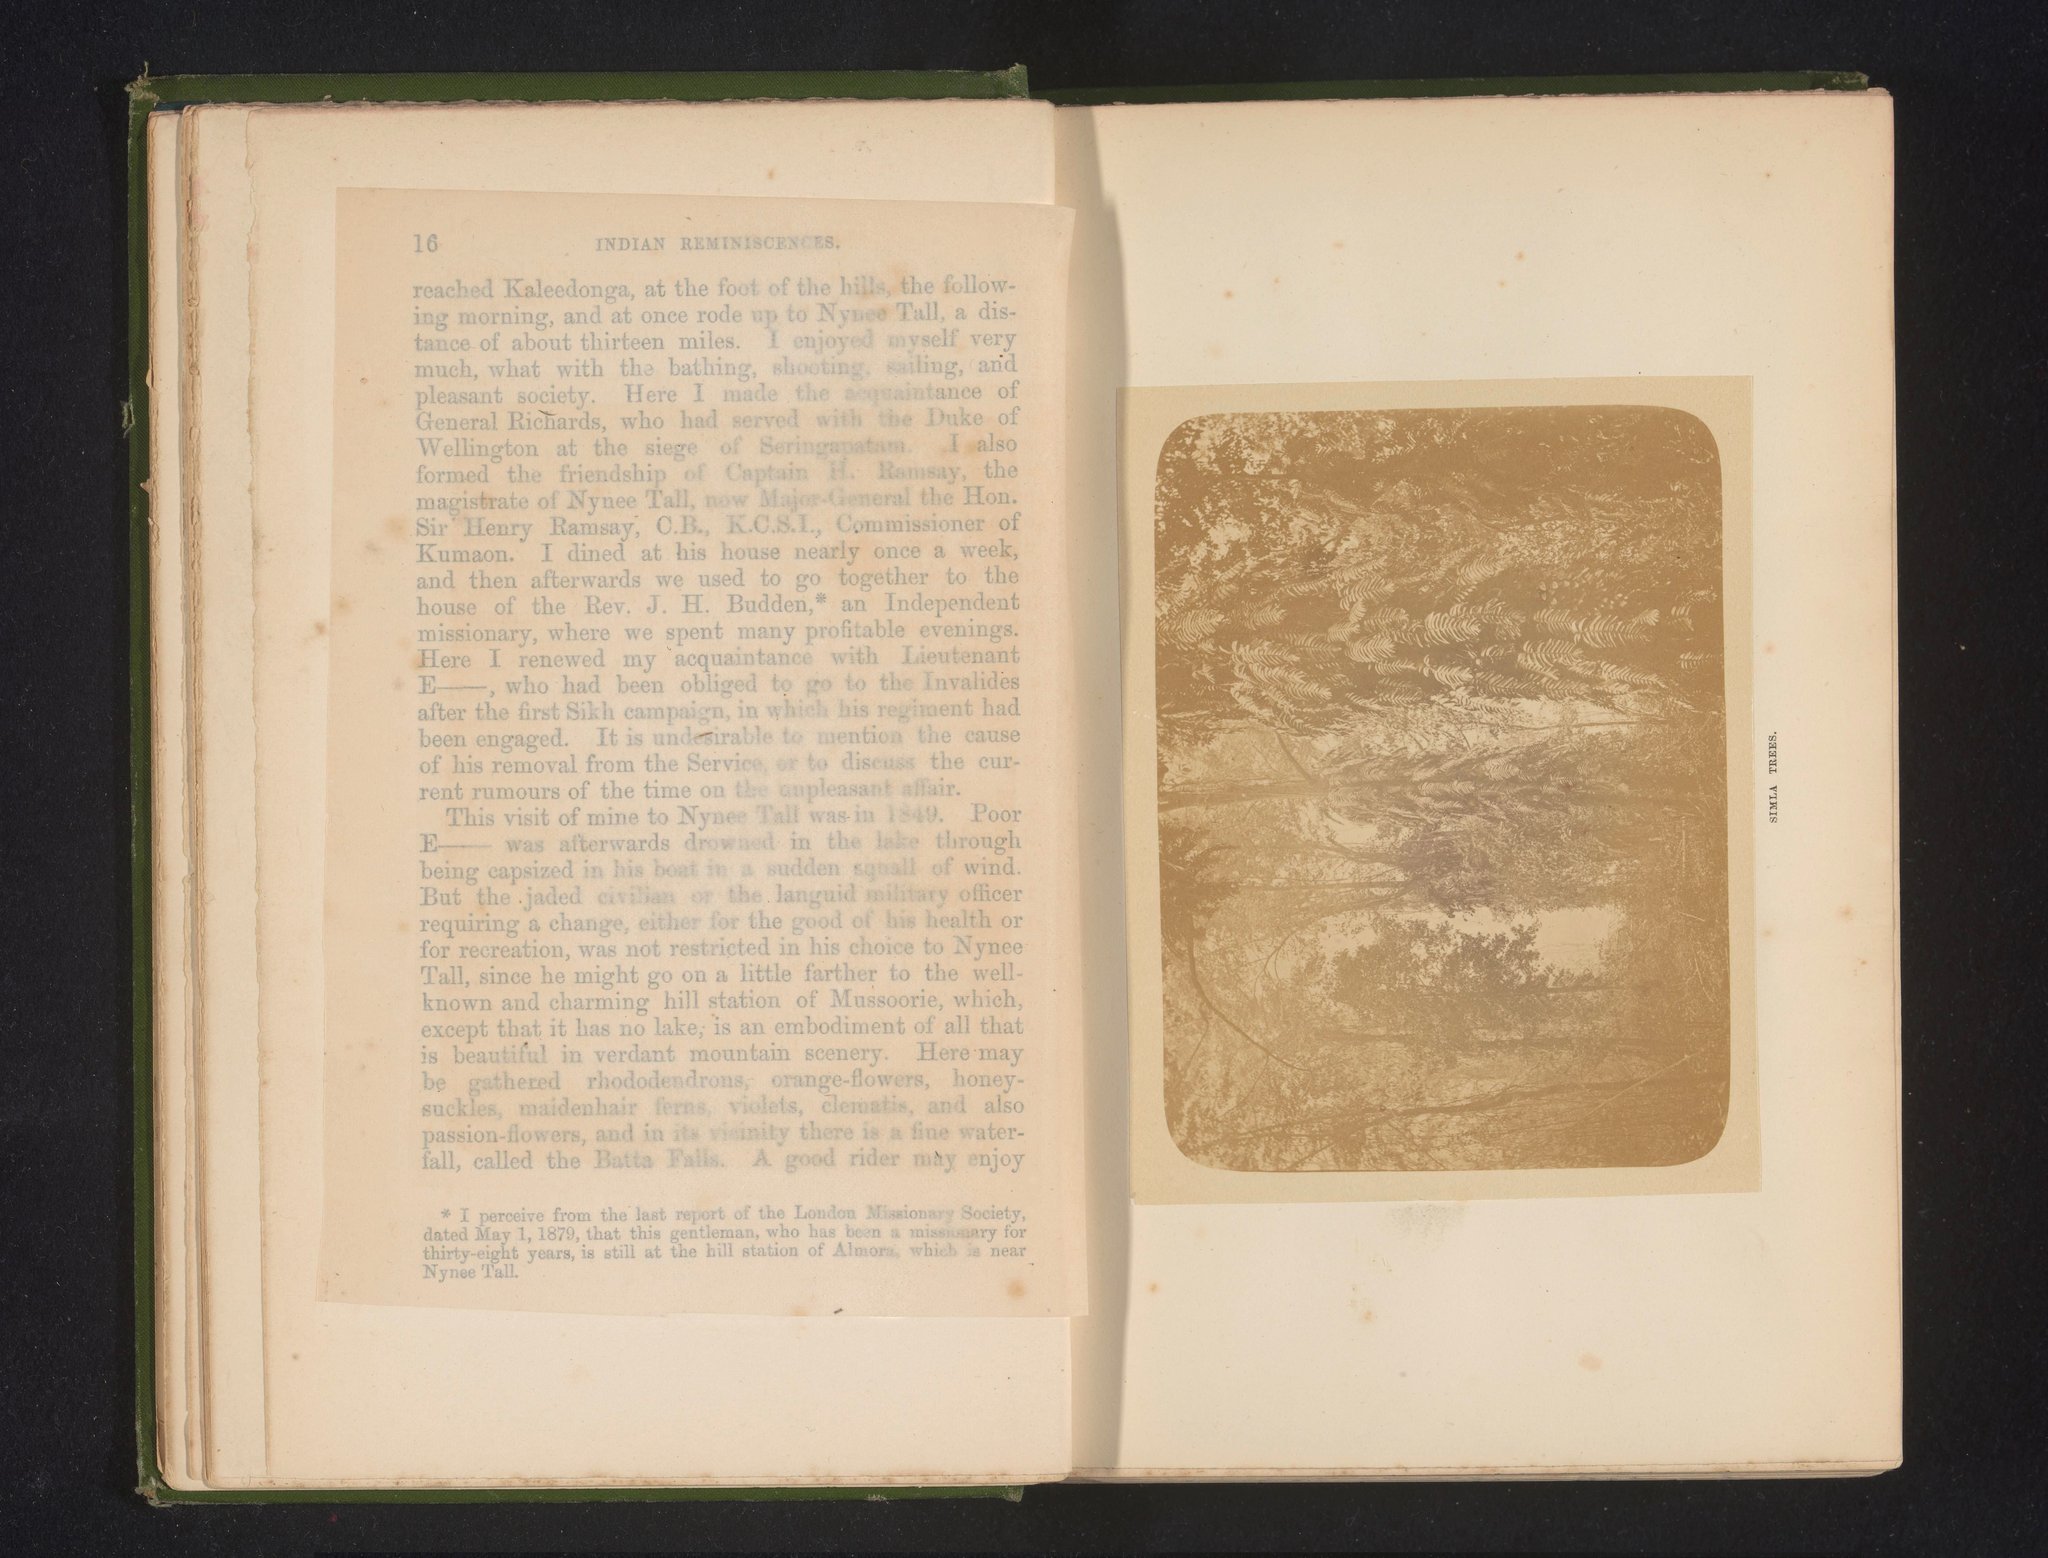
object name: page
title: Simla trees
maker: Anonymous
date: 1870-1880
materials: photographic support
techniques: albumen print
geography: shimla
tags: trees